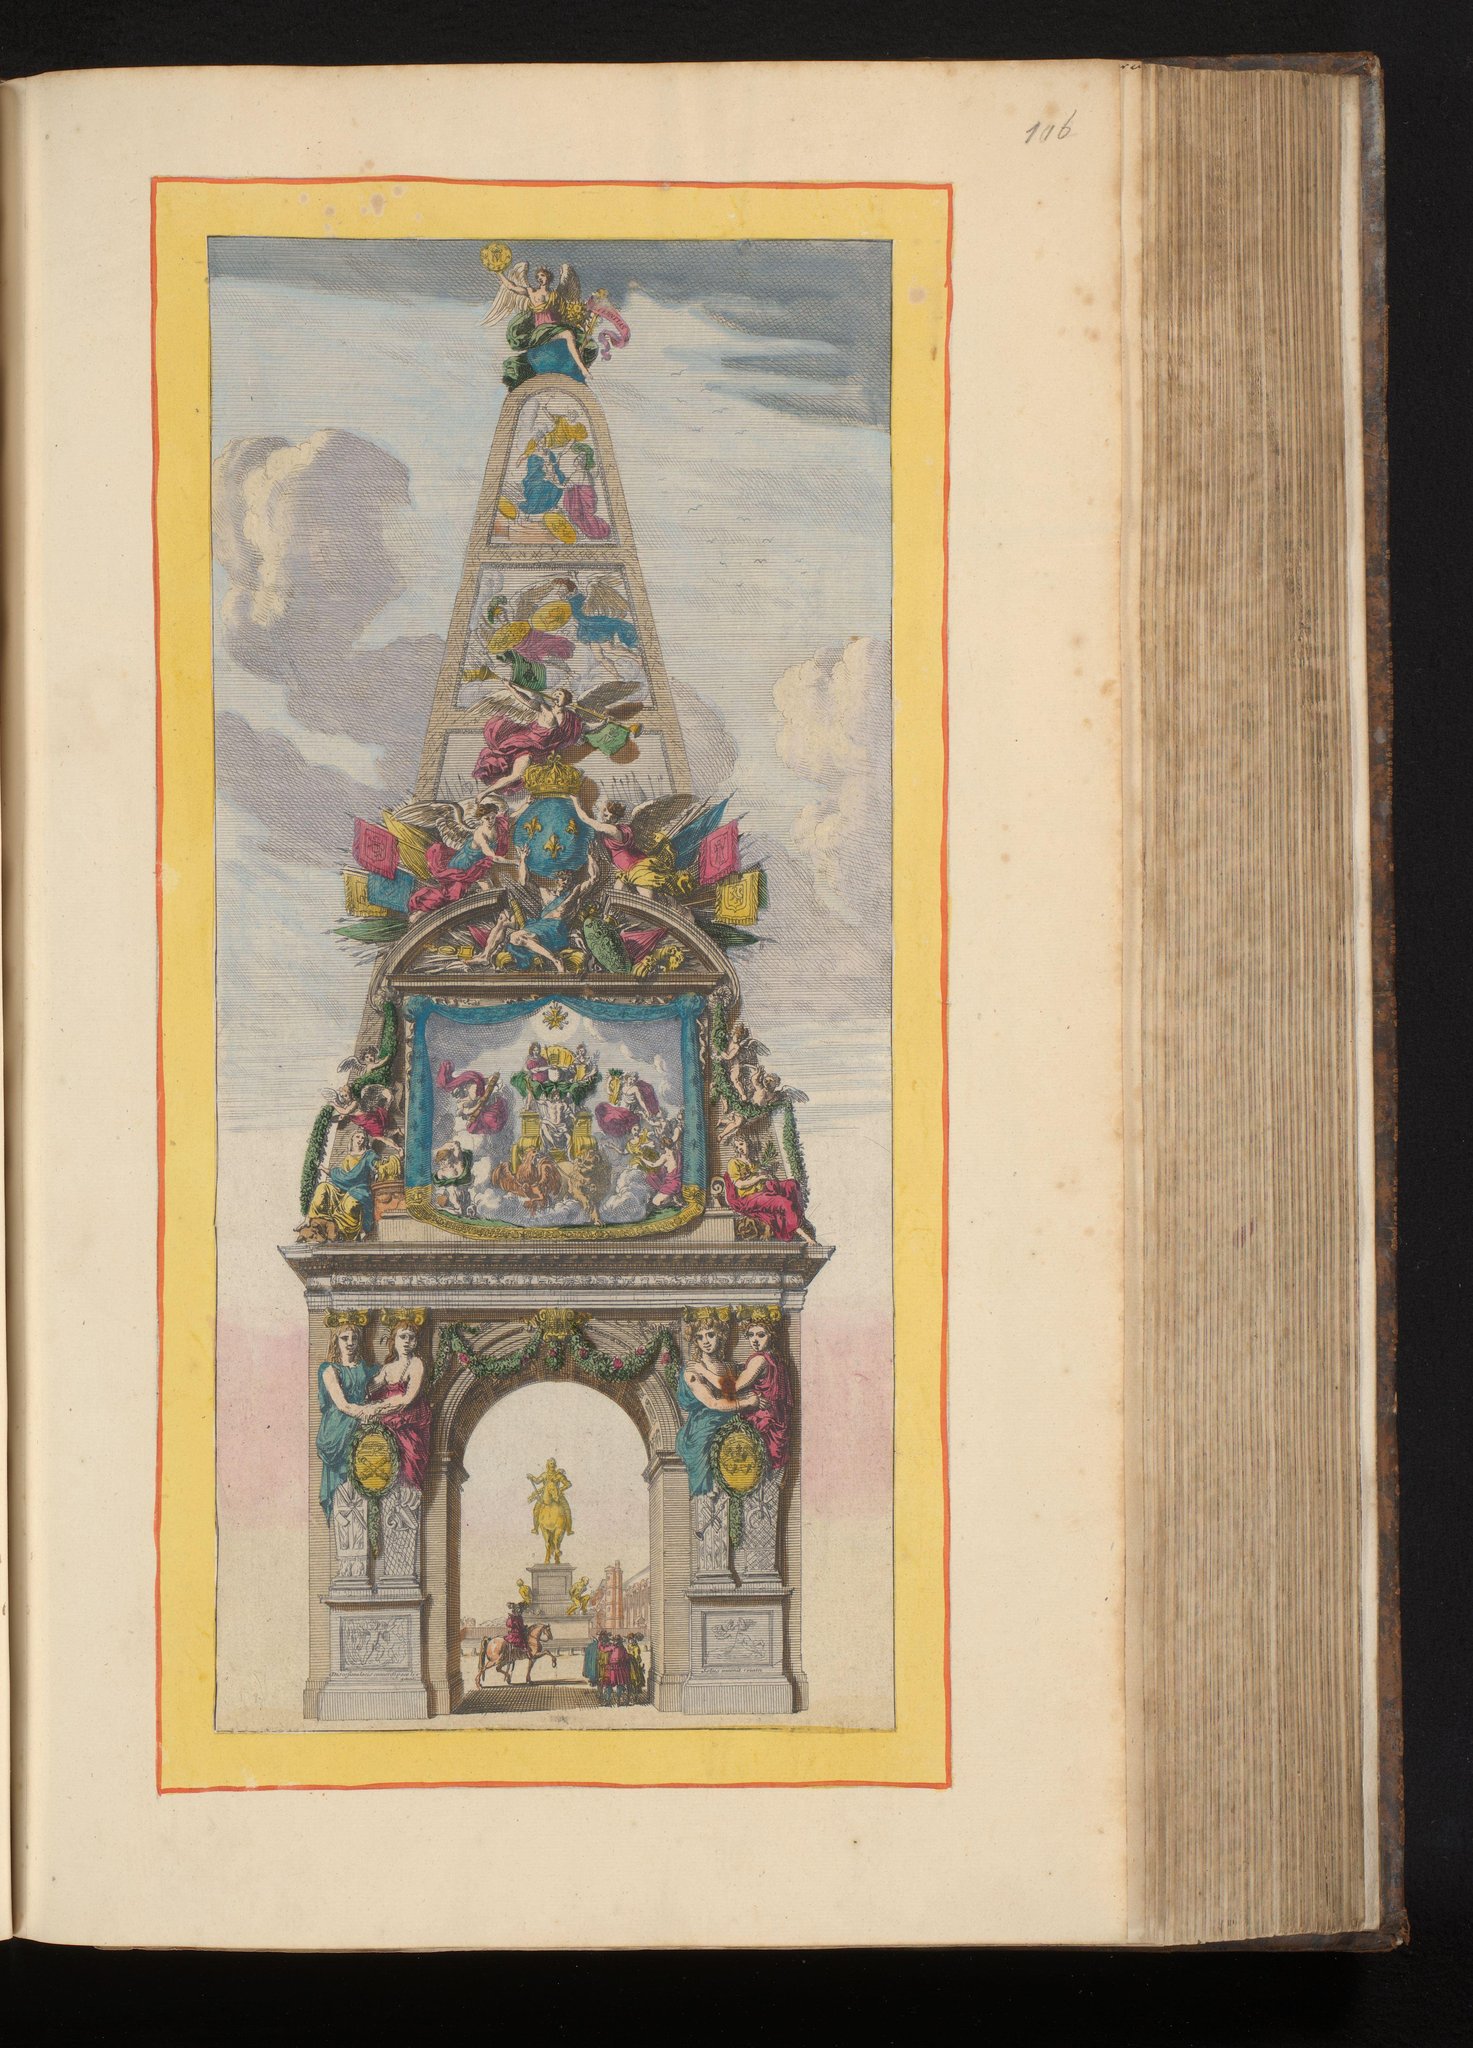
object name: album leaf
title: Obelisk op Place Dauphine tijdens de Blijde Intocht van koning Lodewijk XIV van Frankrijk en zijn vrouw Maria Theresia in Parijs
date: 1660-1662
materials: paper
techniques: etching, hand coloring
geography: the hague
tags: obelisk, needle, triumphal entry and public reception, pageant, 'entrée solennelle', 'joyeuse entrée'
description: Prent uit: L'entrée triomphante de Leurs Majestez Louis XIV, roy de France et de Navarre et Marie-Thérèse d'Austriche, son espouse, dans la ville de Paris ... au retour de la signature de la paix généralle et de leur heureux mariage. Parijs: Pierre le Petit, 1662.